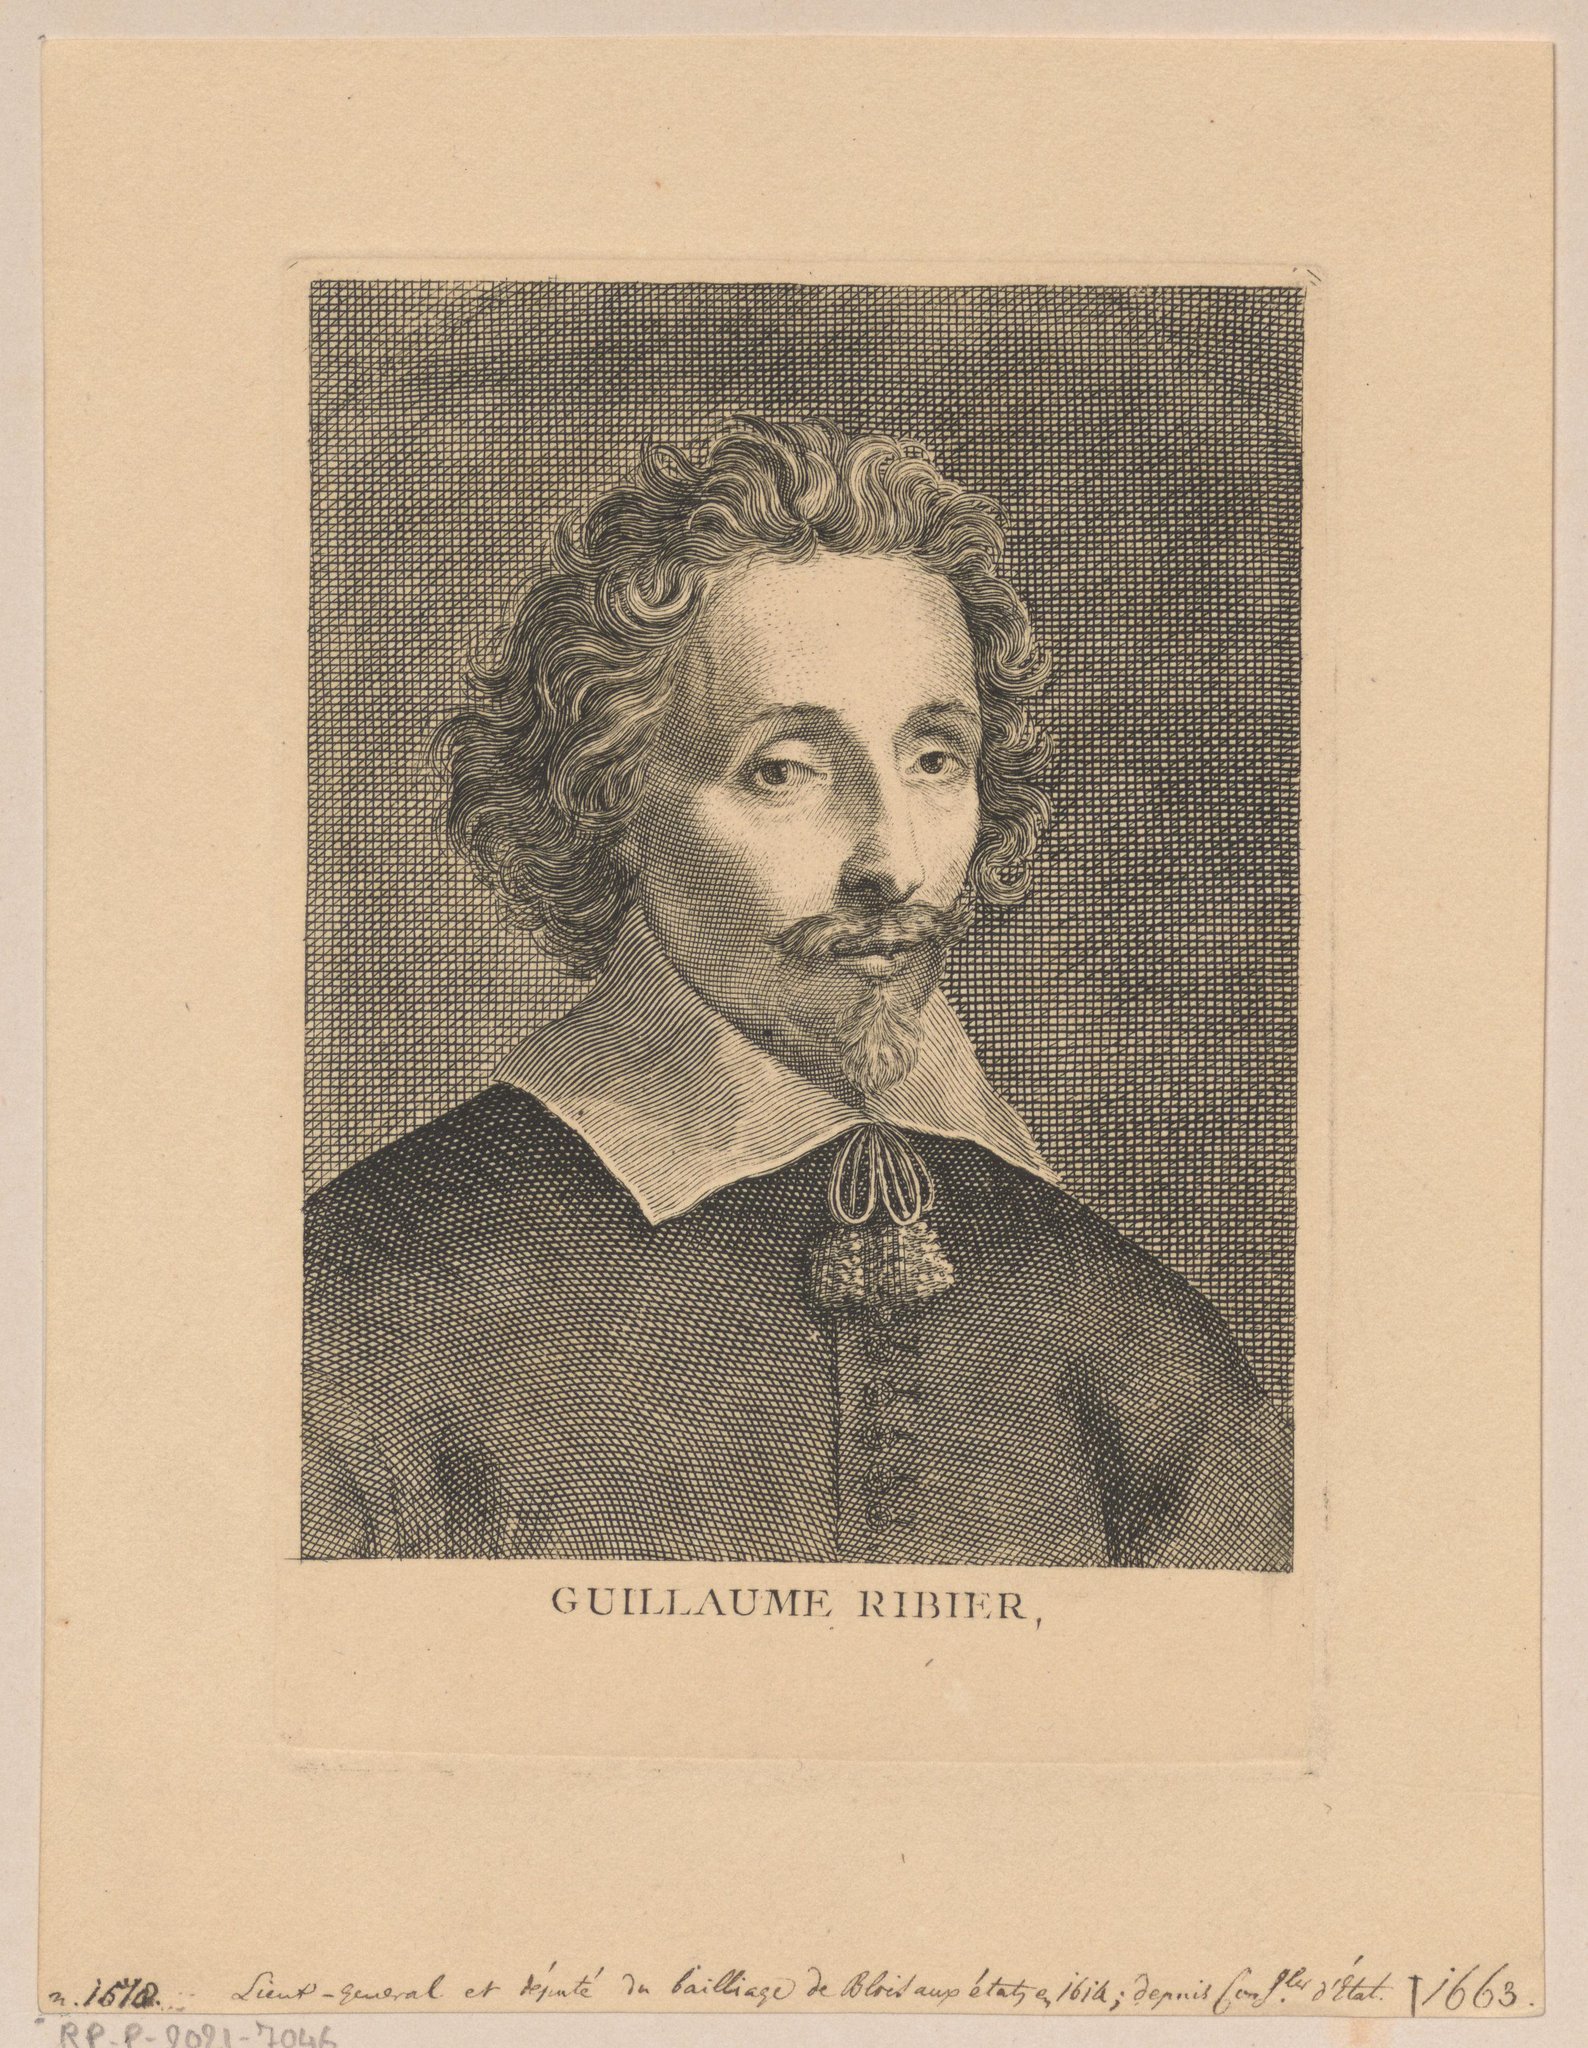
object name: print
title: Portret van Guillaume Ribier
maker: Anonymous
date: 1700-1799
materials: paper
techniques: engraving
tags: politician, historical persons